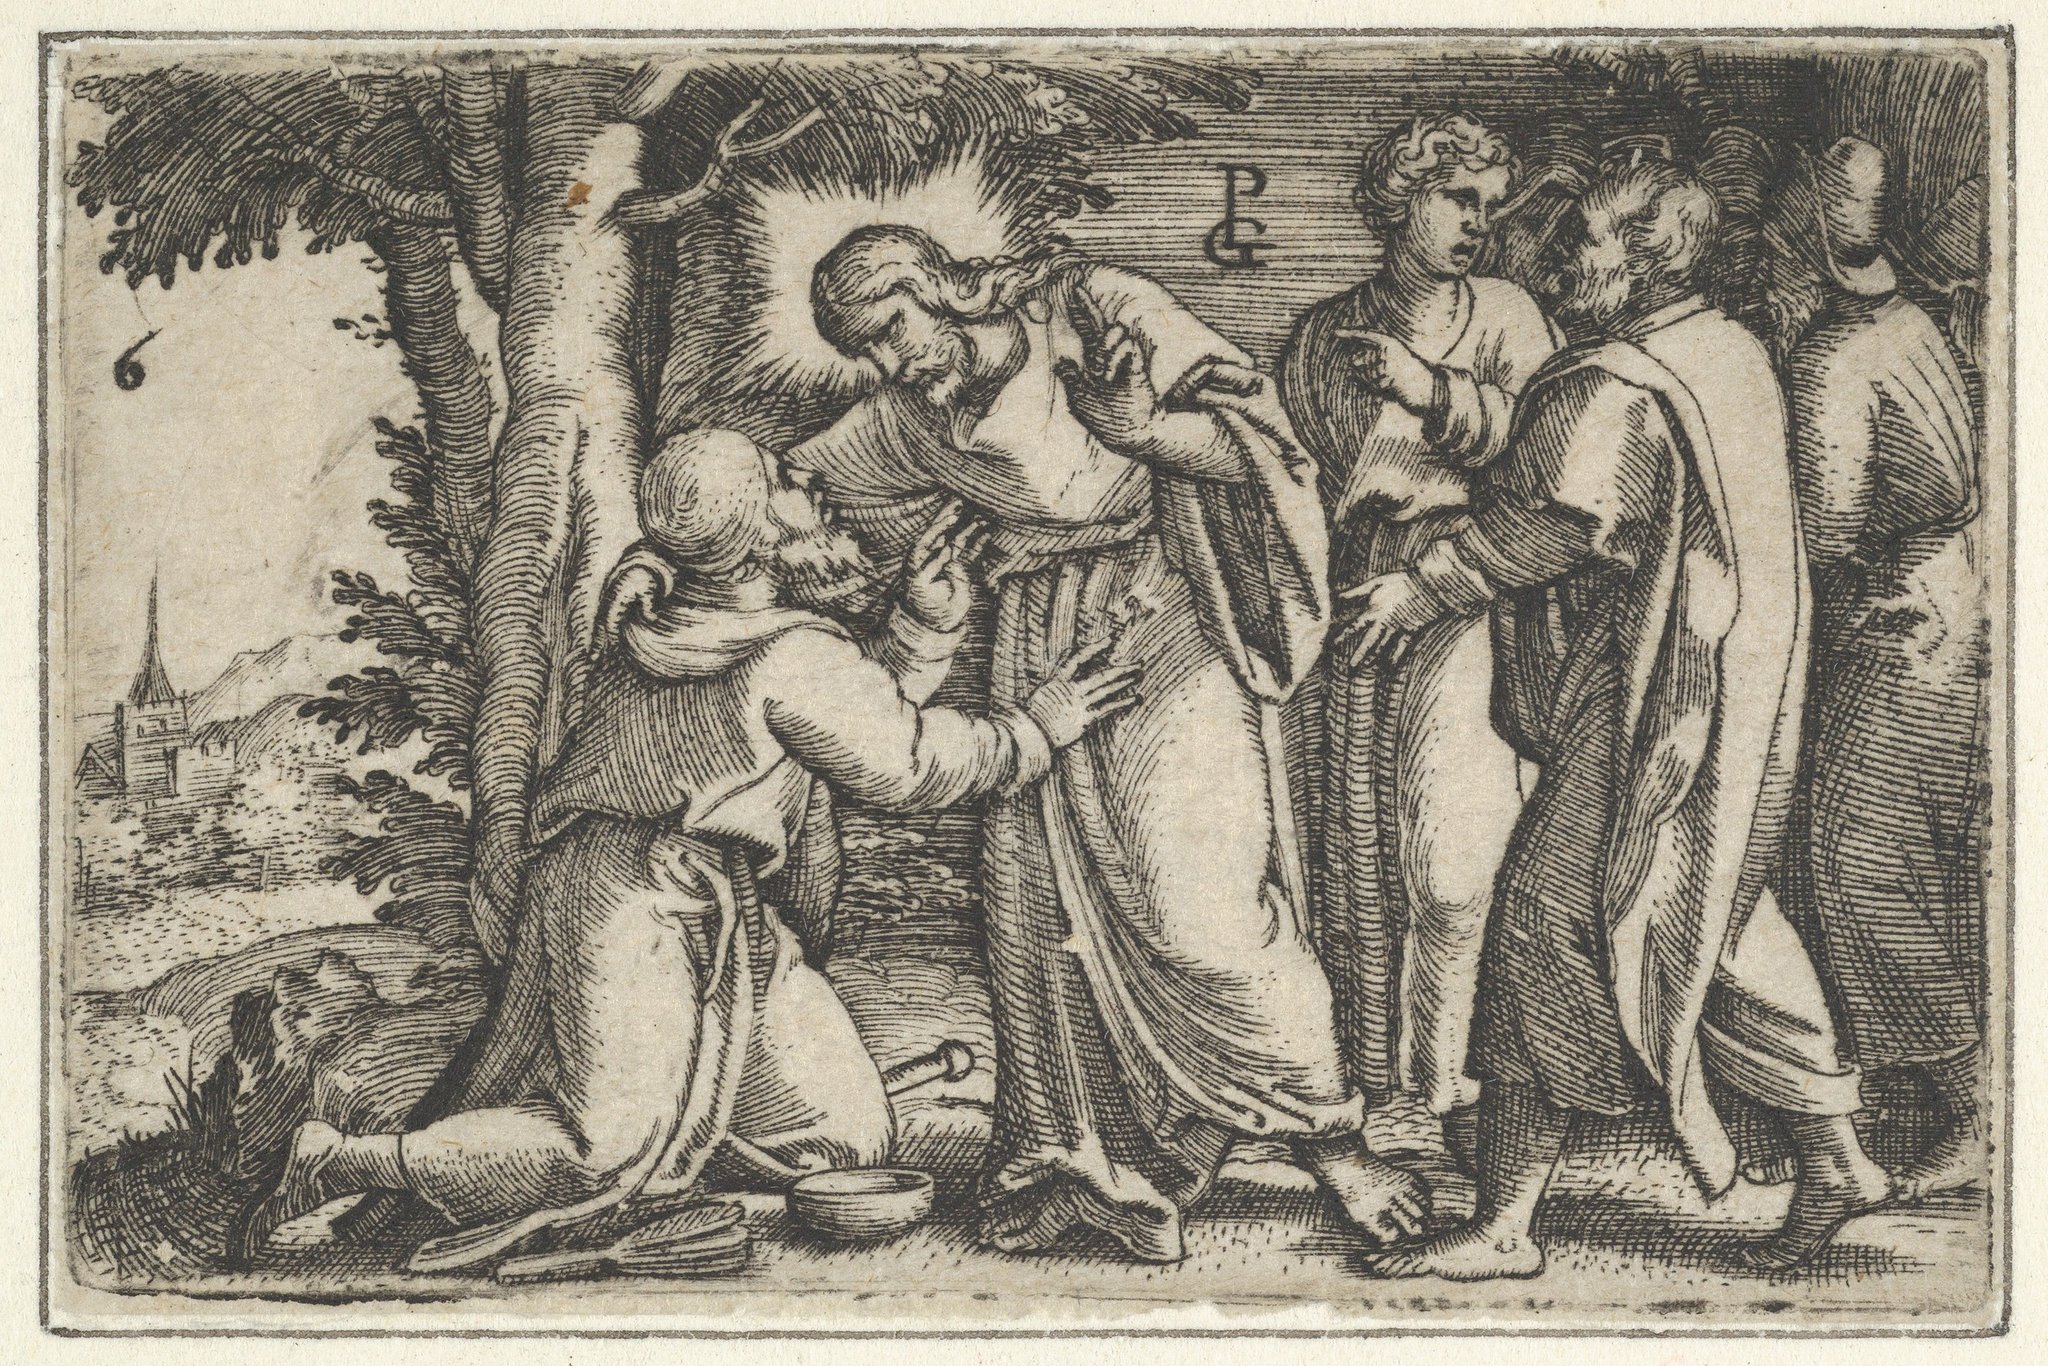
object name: print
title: Christ Healing the Leper, from The Story of Christ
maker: georg pencz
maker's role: artist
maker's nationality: german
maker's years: 1500-1550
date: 1534-1535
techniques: engraving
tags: illness,men,christ